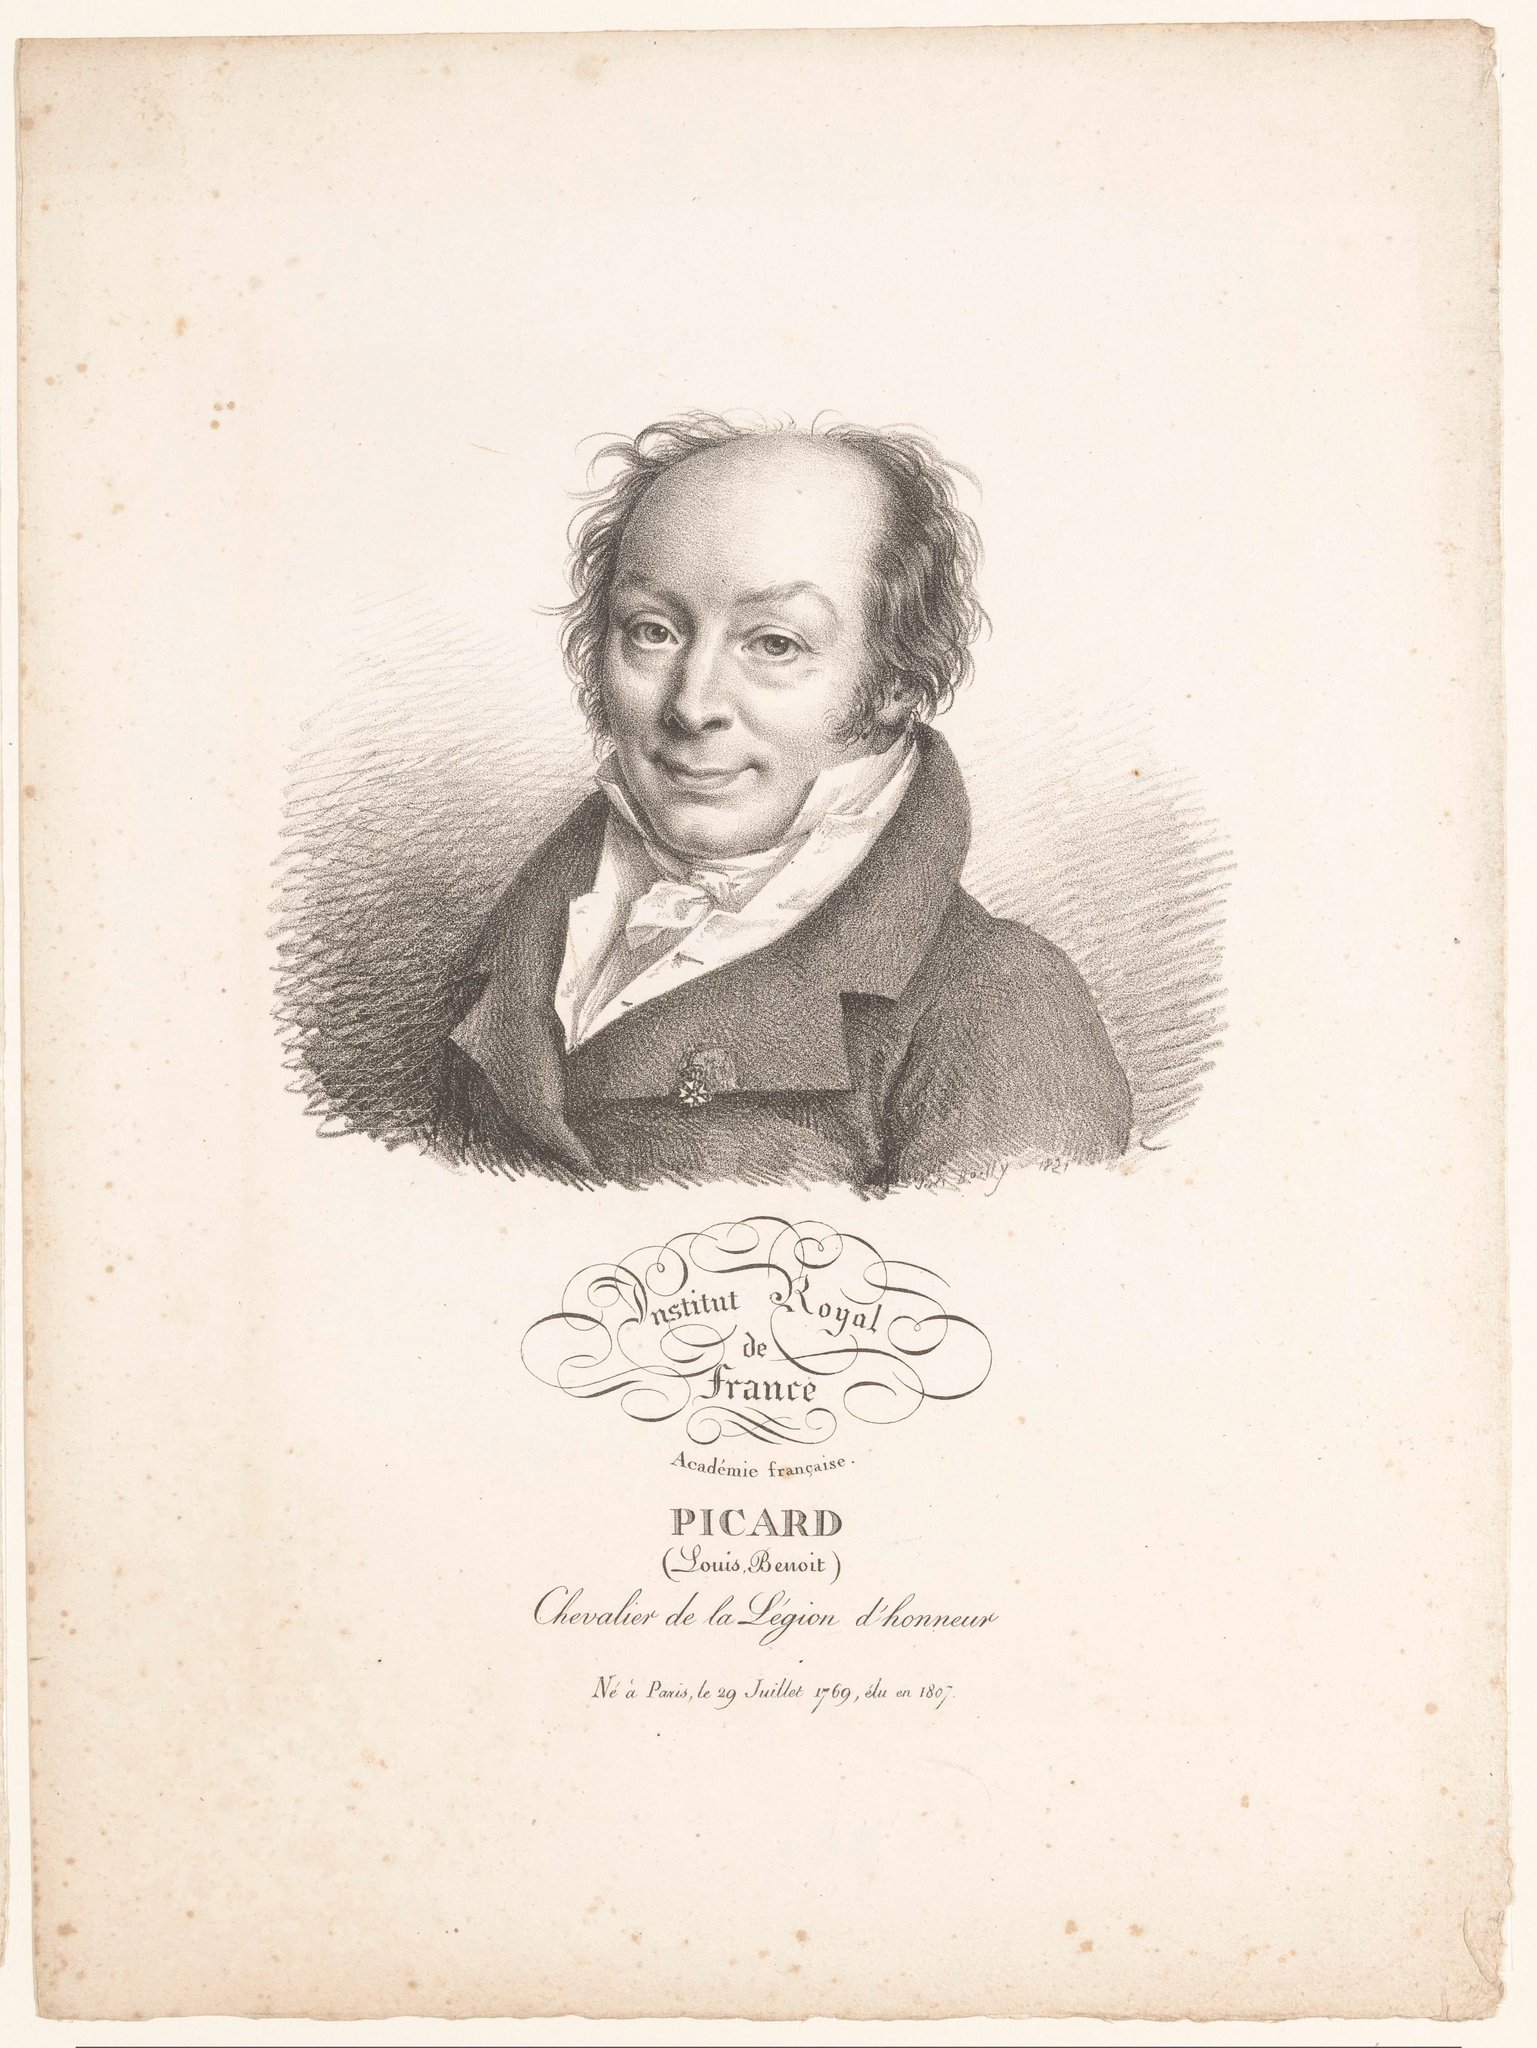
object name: print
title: Iconographie de l'Institut Royal de France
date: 1821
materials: paper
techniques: lithograph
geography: paris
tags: paris, historical persons, portrait of a writer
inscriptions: collector's mark: Lugt 2228a